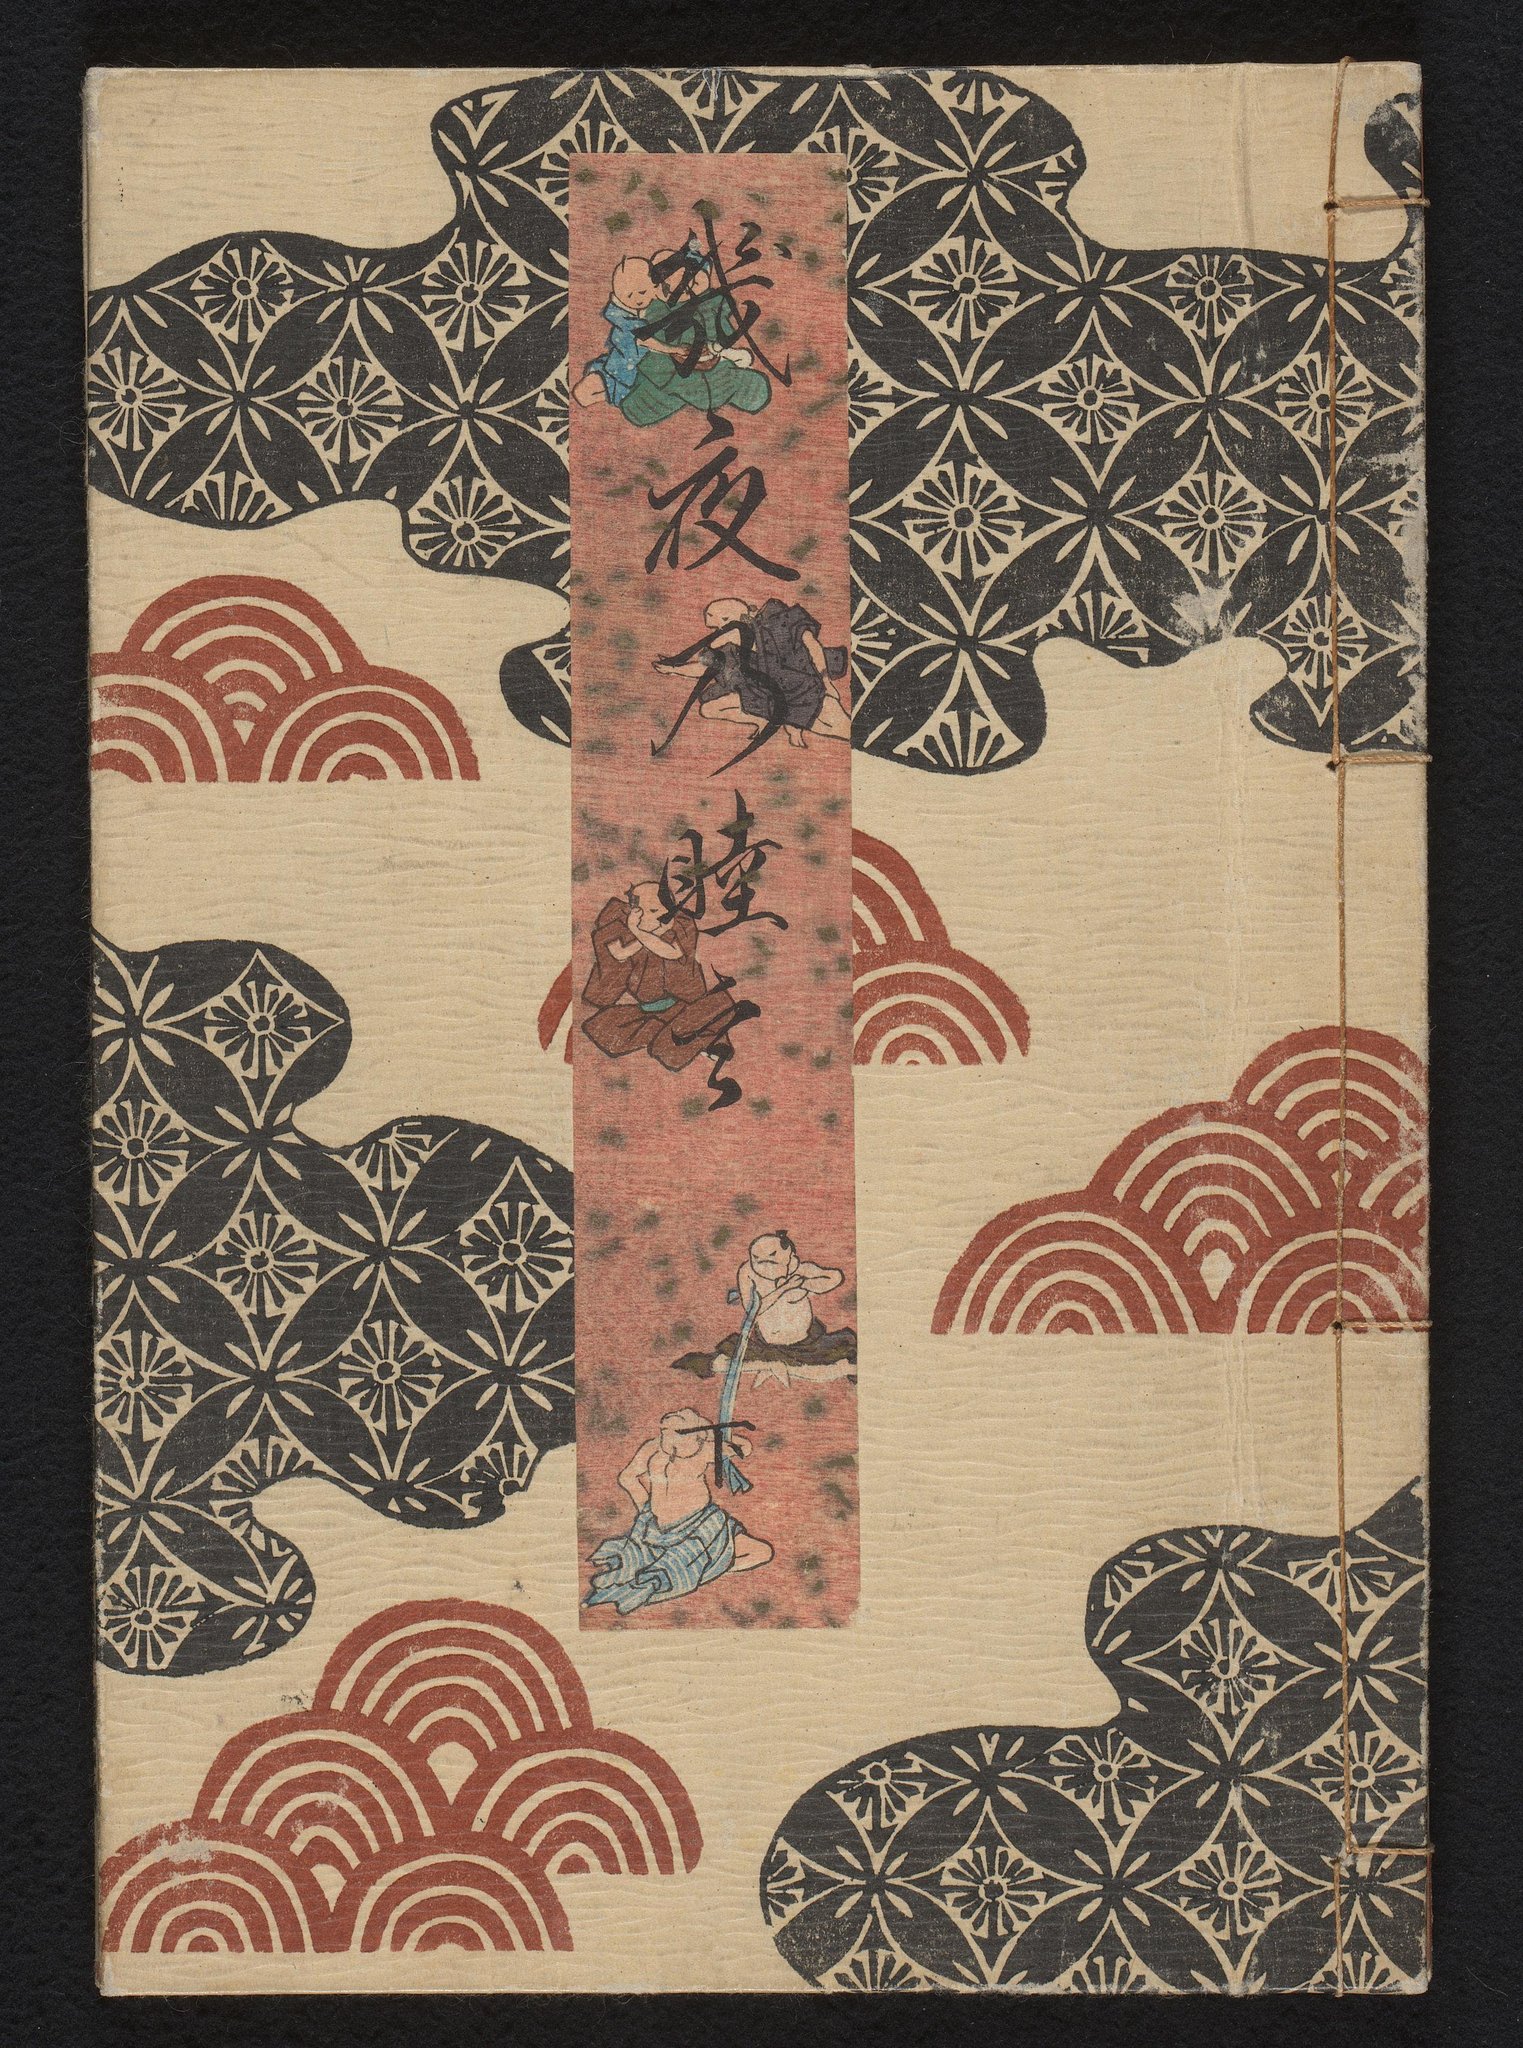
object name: book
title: Whispered intimacies between lovers awake in bed on nights for end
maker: utagawa kunisada (i)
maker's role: print maker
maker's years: 1786-1865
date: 1849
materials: paper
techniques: woodcut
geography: japan